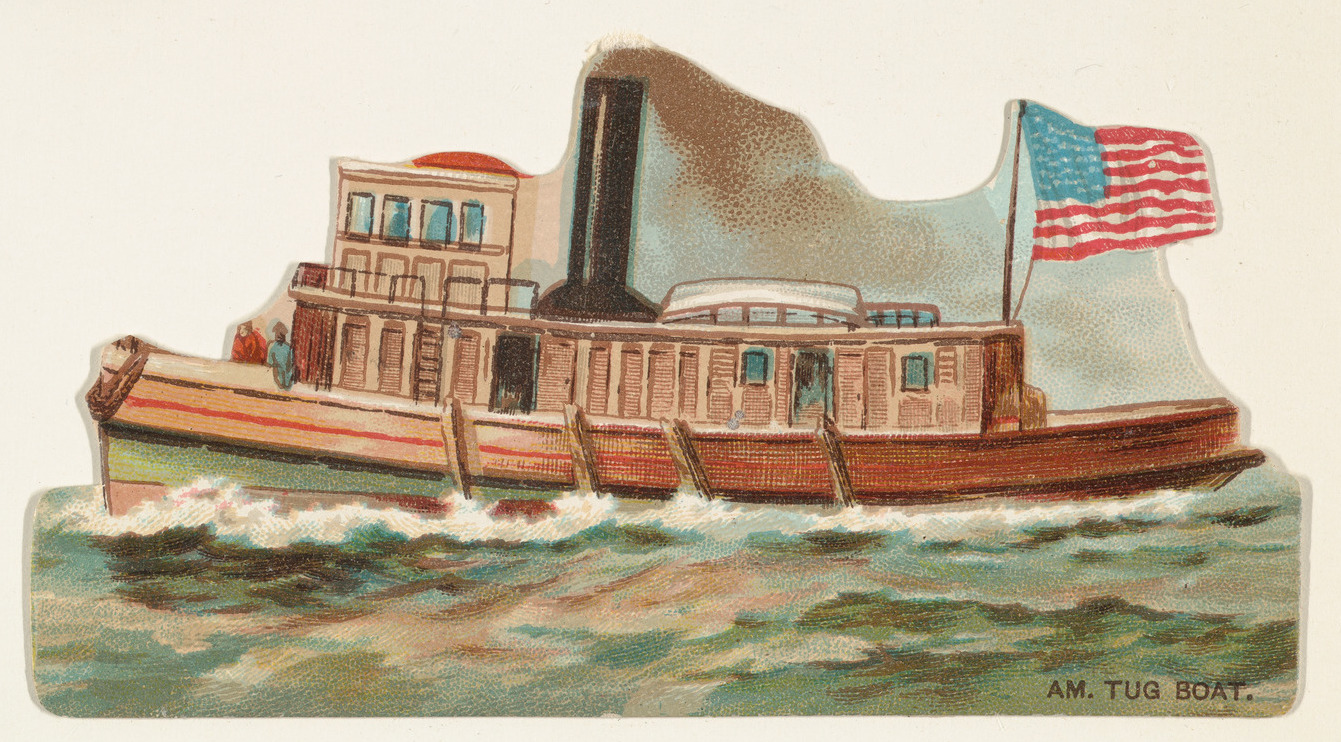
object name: print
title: American Tugboat, from the Types of Vessels series (N139) issued by Duke Sons & Co. to promote Honest Long Cut Tobacco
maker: w. duke, sons & co.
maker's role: publisher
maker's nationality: american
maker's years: 1870-1920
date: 1889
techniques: color lithograph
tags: boats